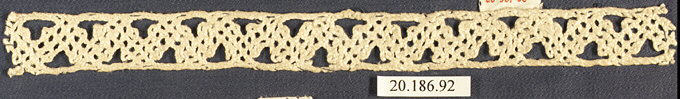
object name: insertion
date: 1501-1600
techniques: lace